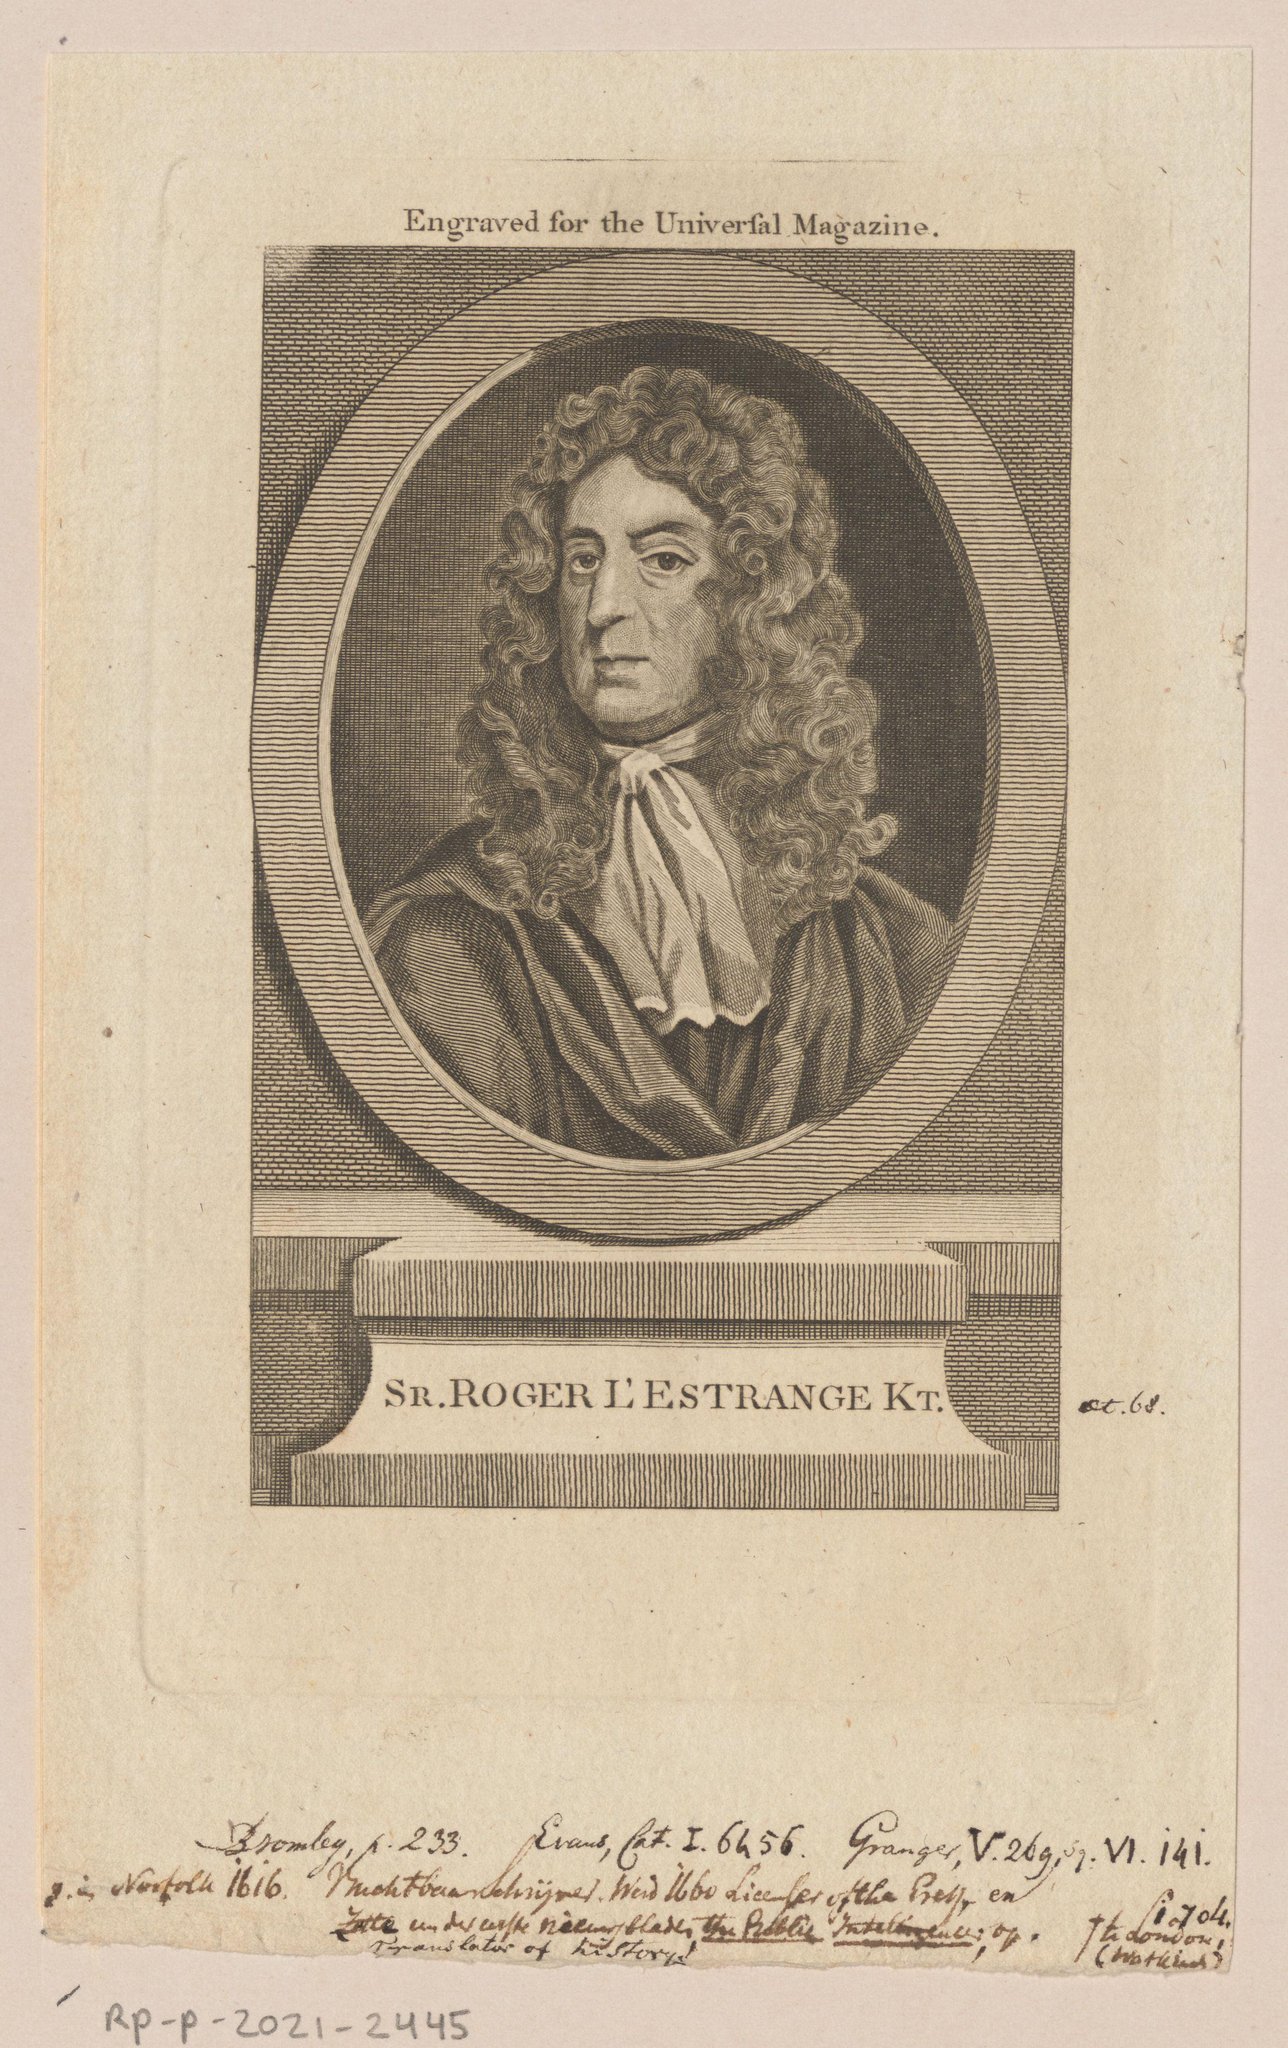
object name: print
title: Portret van Roger L'Estrange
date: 1781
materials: paper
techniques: etching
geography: england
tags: london, ornament ~ medallion, historical persons, portrait of a writer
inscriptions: inscription: ‘Bromley, p. 233 (...)/ Norfolk 1616 (...)’, inscription: ‘[...] 68’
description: Prent waarschijnlijk uit: The Universal Magazine (...) (1781), vol. 68, juni 1781.